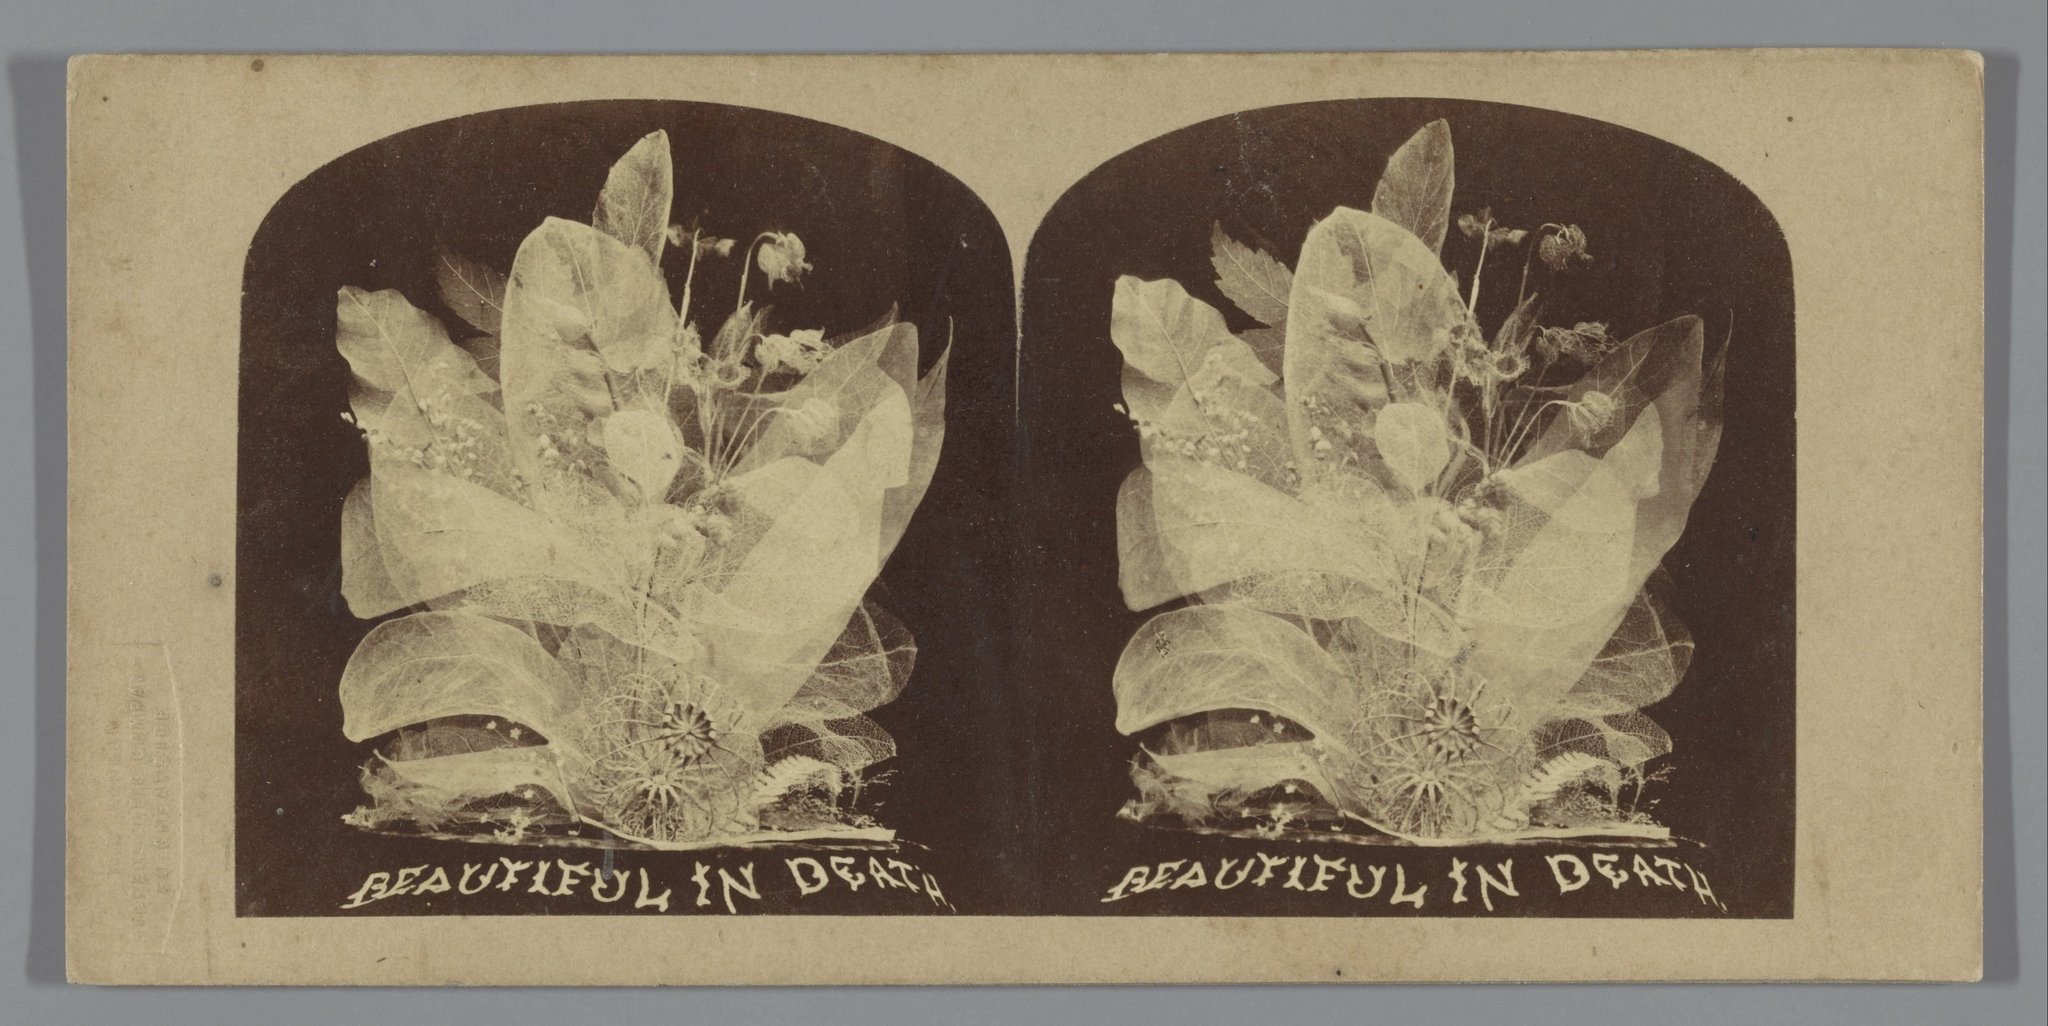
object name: stereograph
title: Stilleven met gedroogde planten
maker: william england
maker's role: fotograaf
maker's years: 1816-1896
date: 1858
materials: cardboard, photographic support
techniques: albumen print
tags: dried flowers, still life of miscellaneous objects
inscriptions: number: ‘60’, : ‘G de Ranitz’